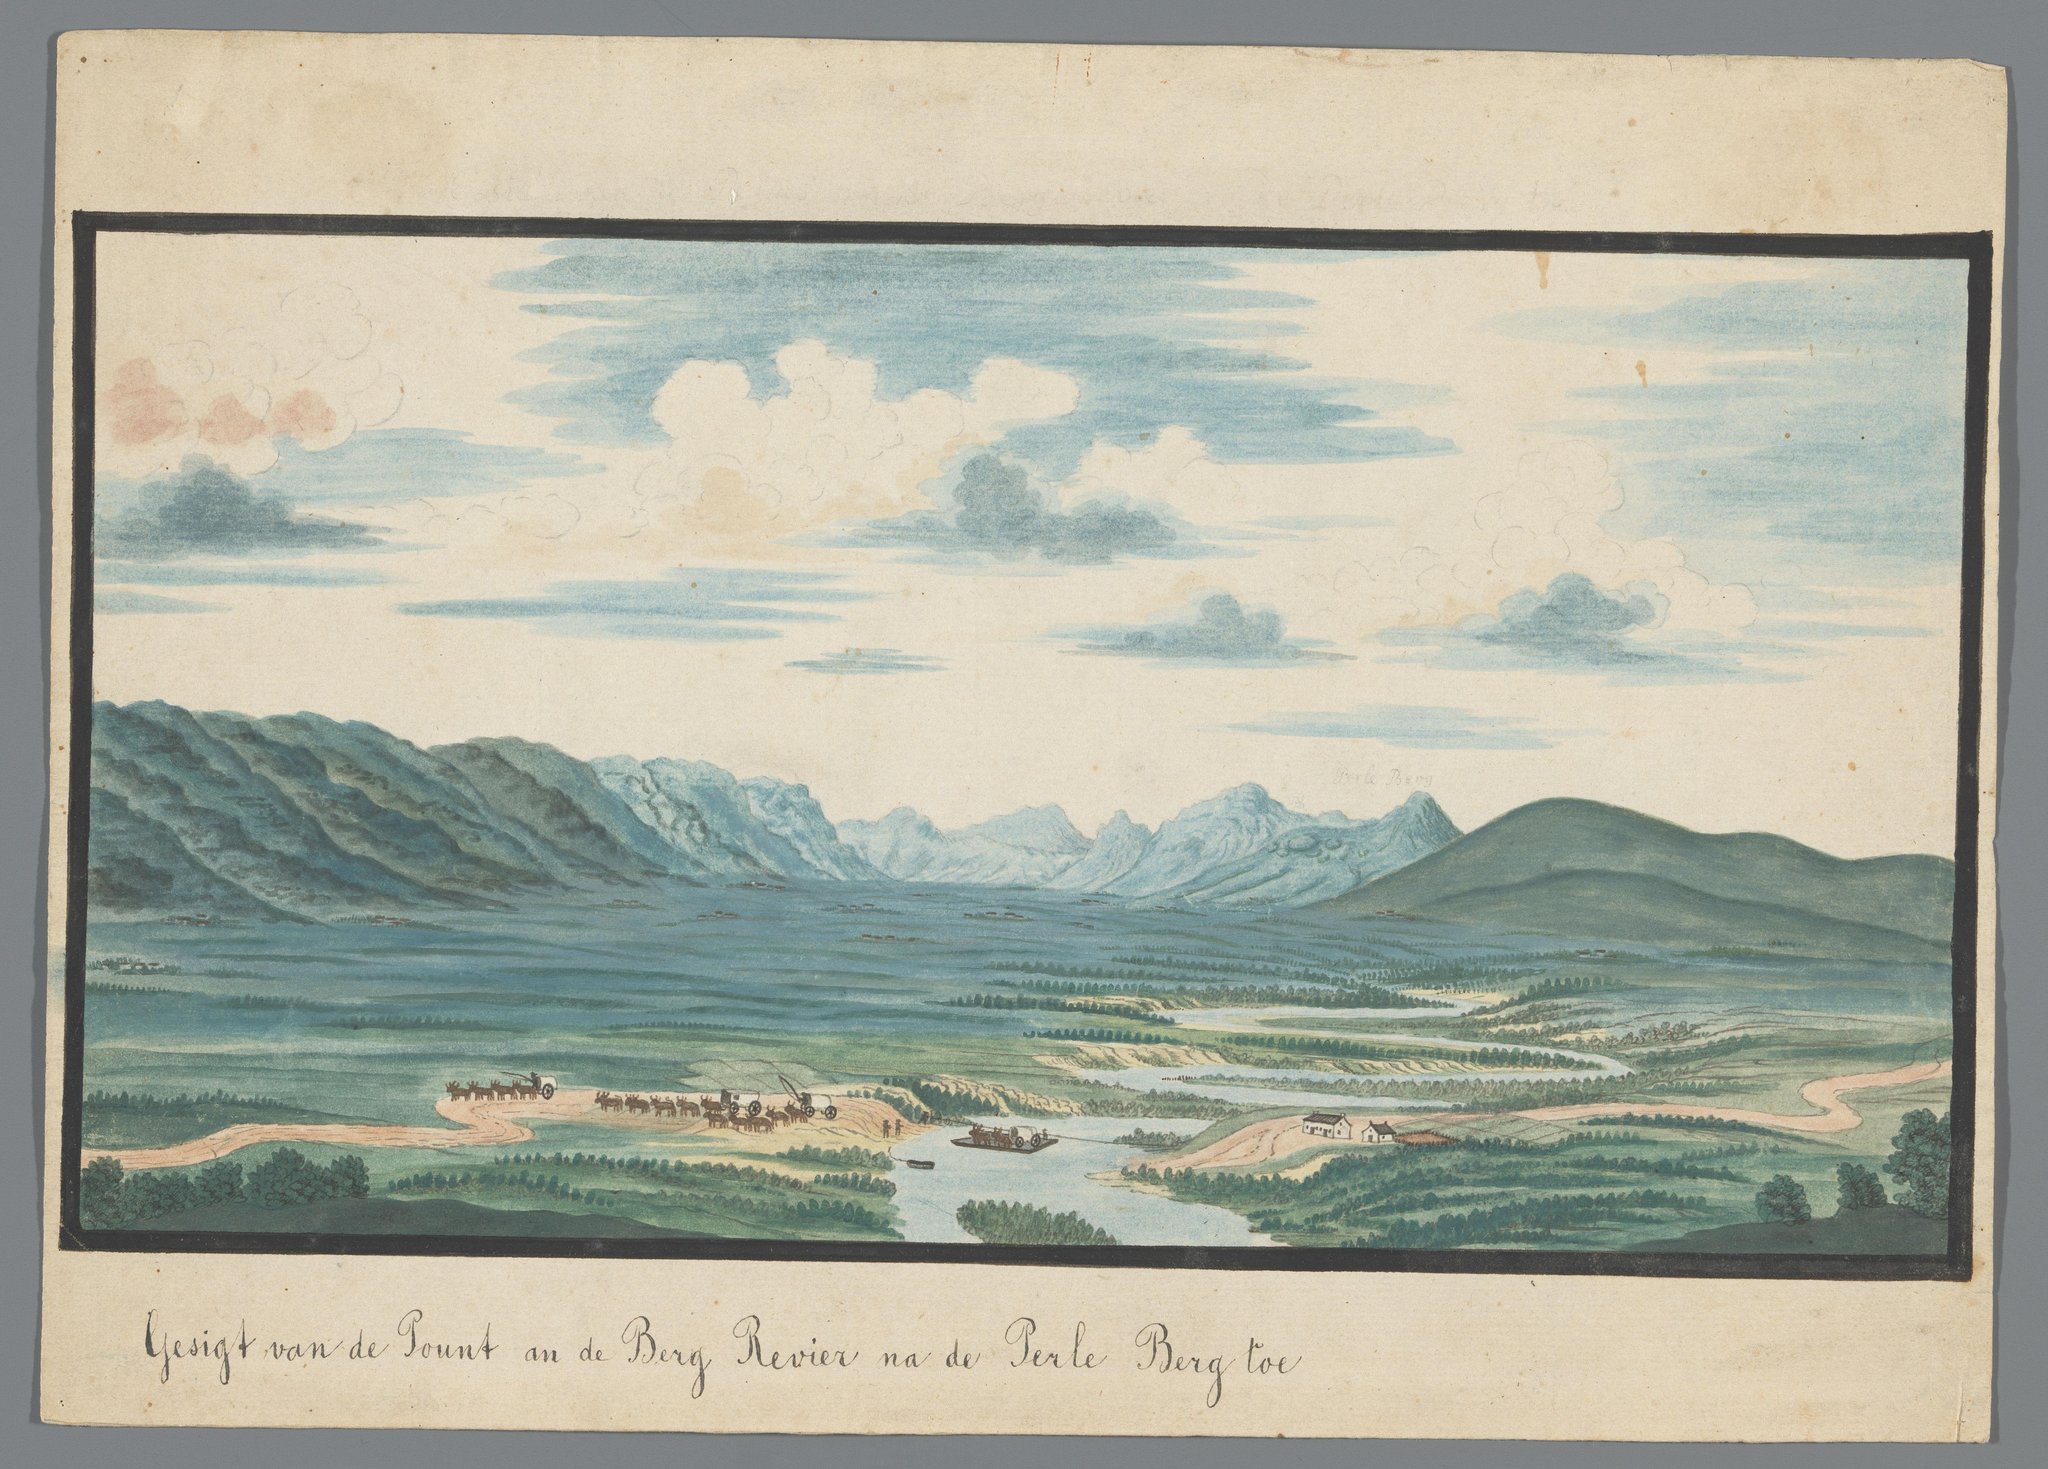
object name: drawing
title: Pont over de Bergrivier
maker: johannes schumacher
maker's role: draughtsman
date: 1709-1776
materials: paper, watercolor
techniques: brush, pen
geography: south africa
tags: cape of good hope, river, ferry, covered wagon, hooded wagon, mountain-range, snow peaks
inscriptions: label: ‘43’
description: Pont over de Bergrivier, bij de Paarlberg. In de verte de Drakensbergen. De ossenwagens maken een voor een de oversteek. Tekening gemaakt tijdens de tweede reis van Hendrik Swellengrebel, naar het noordoosten van de Kaapkolonie, 10 september - 26 december 1776. Volgens het reisjournaal nam het reisgezelschap de veerboot over de Bergrivier op 10 september 1776.